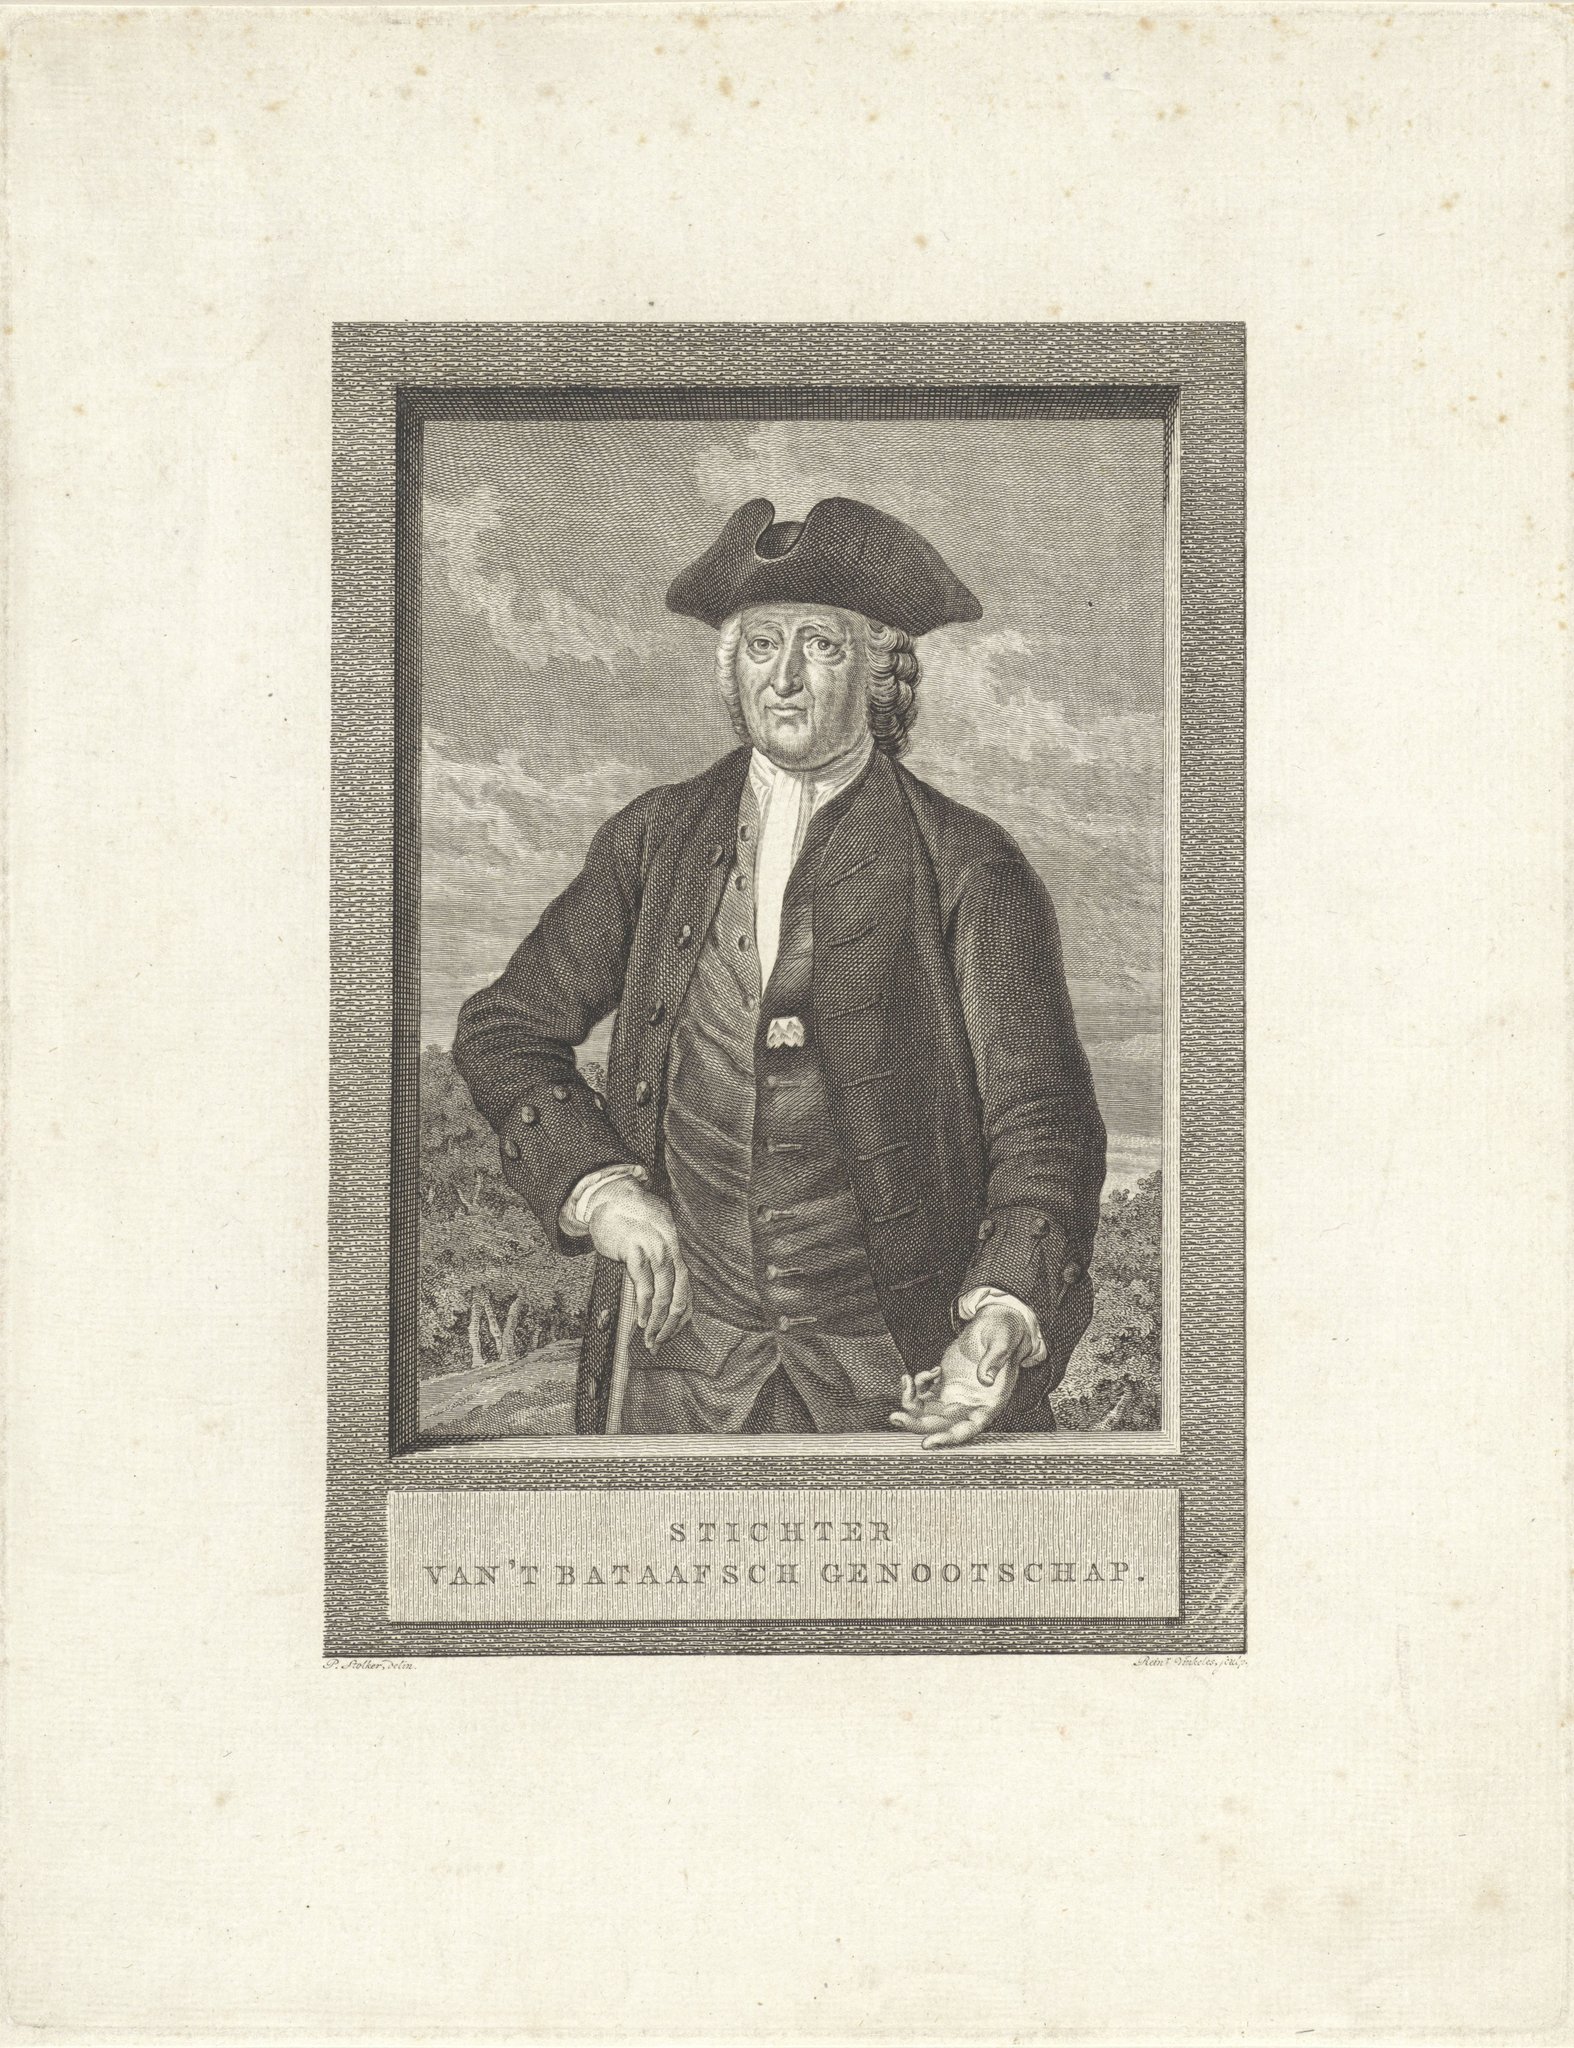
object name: print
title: Stichter van 't Bataafsch Genootschap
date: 1774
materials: paper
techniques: engraving, etching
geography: amsterdam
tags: physicist, instrument maker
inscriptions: collector's mark: Lugt 2228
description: Portret van Steven Hoogendijk, Rotterdamse horloge- en instrumentmaker en natuurkundige en oprichter van het Bataafs Genootschap voor Proefondervindelijke wijsbegeerte in 1769.